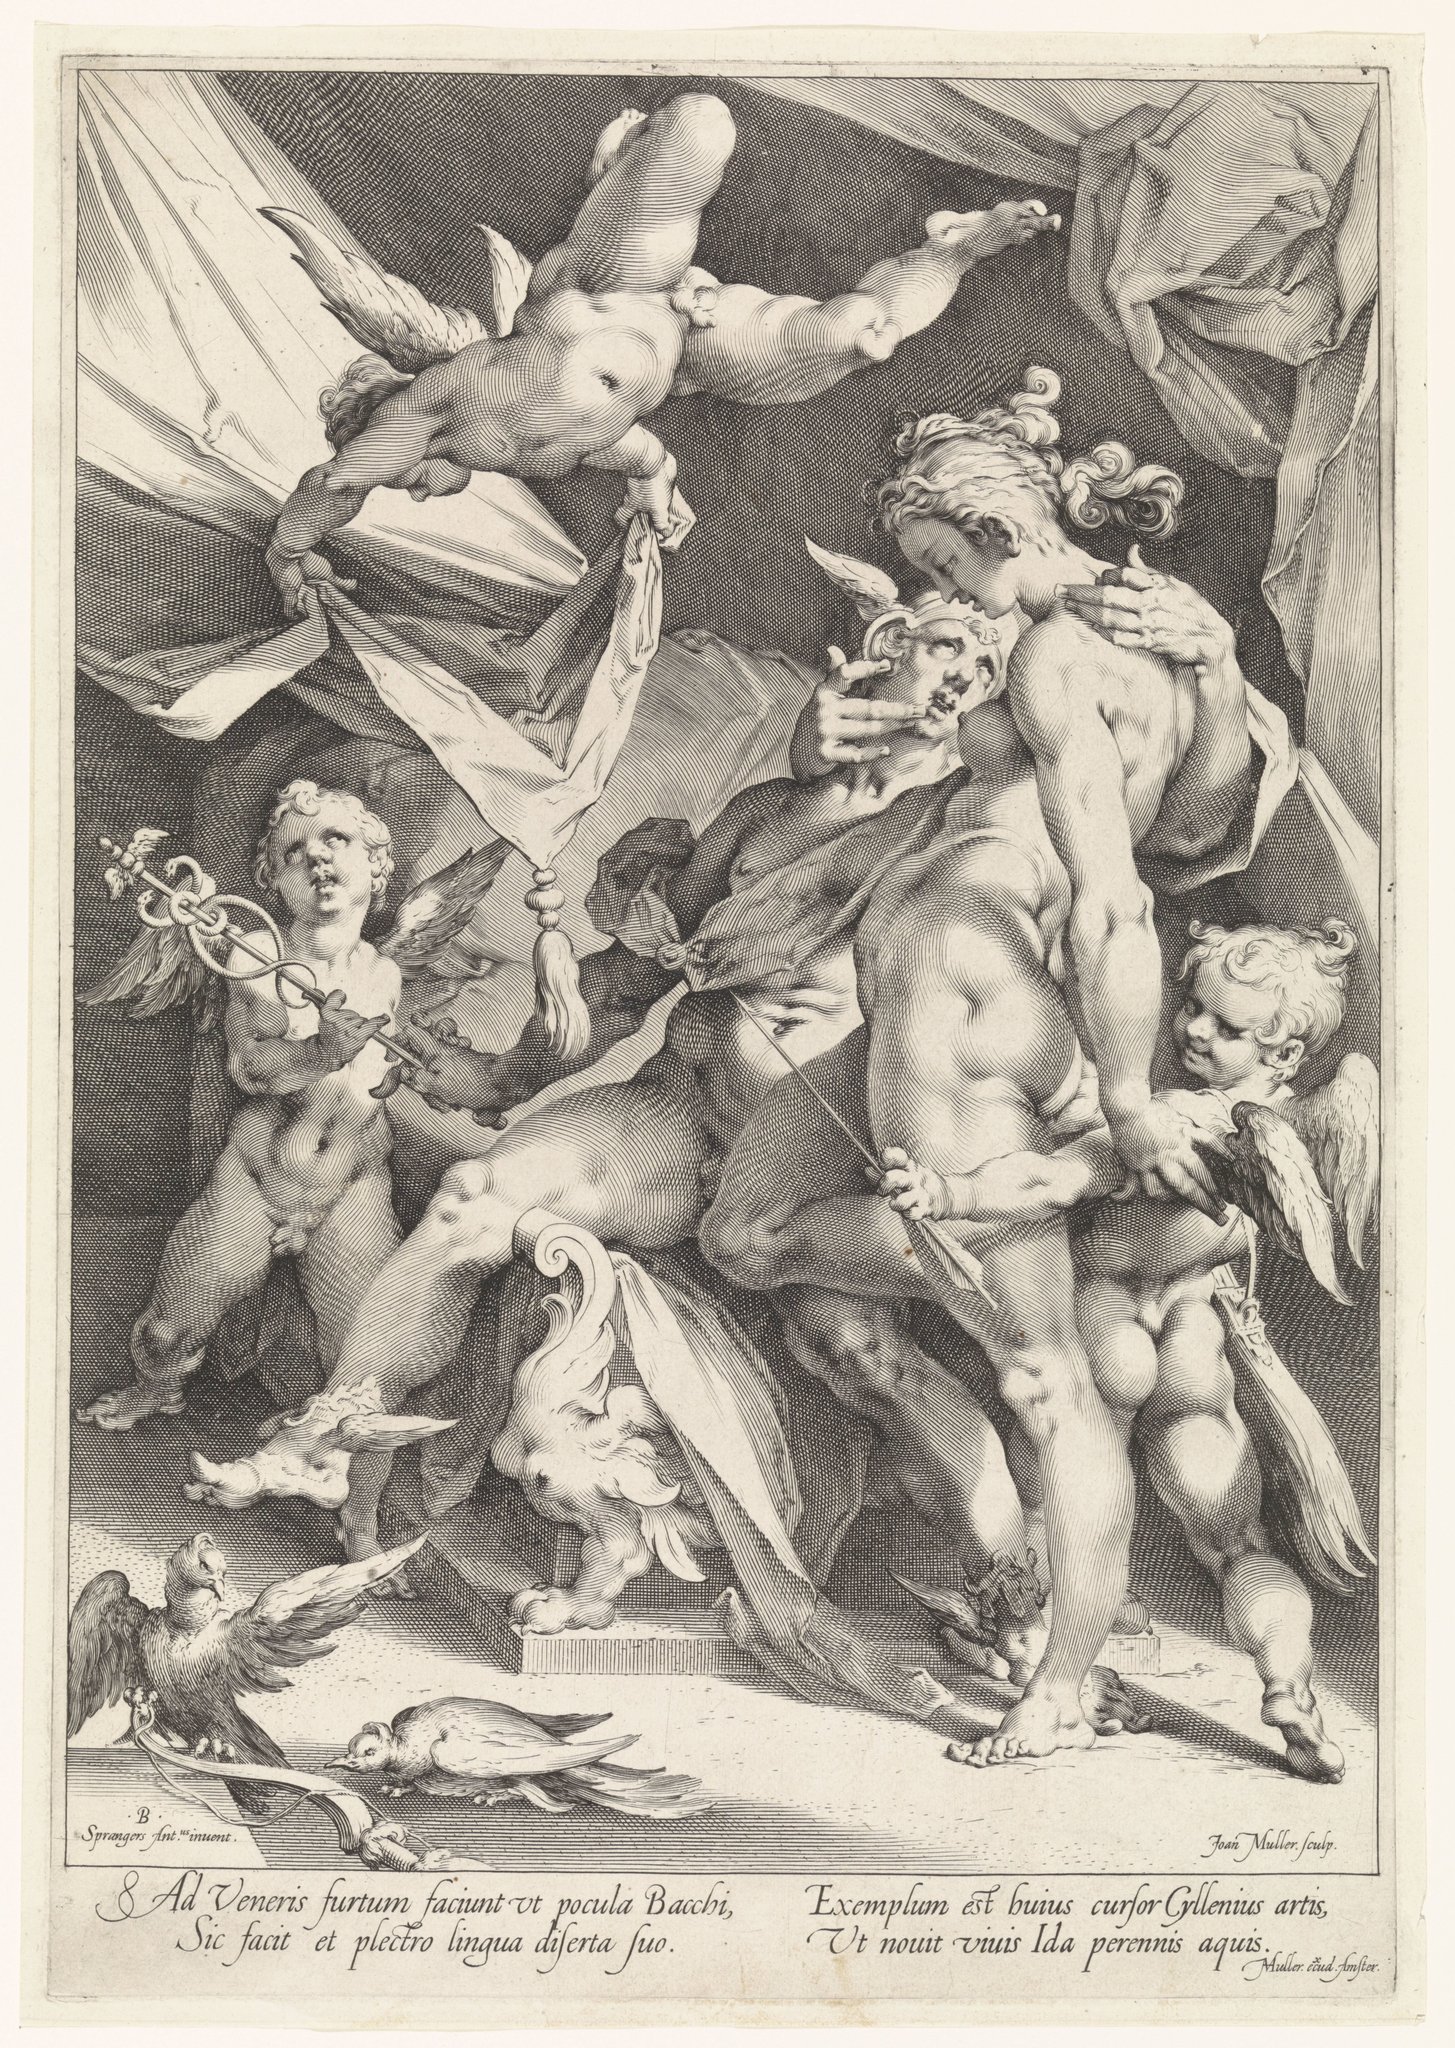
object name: print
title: Venus and Mercury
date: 1598-1602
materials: paper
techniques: engraving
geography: amsterdam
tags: (story of) cupid, amor (eros), mercury and venus as lovers, doves, pigeons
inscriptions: collector's mark: Lugt 240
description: Mercurius en Venus omhelzen elkaar. Achter Venus staat Amor met een pijl in zijn hand. Een putto pakt de caduceus van Mercurius aan. Op de voorgrond twee duiven bij de boog van Amor.